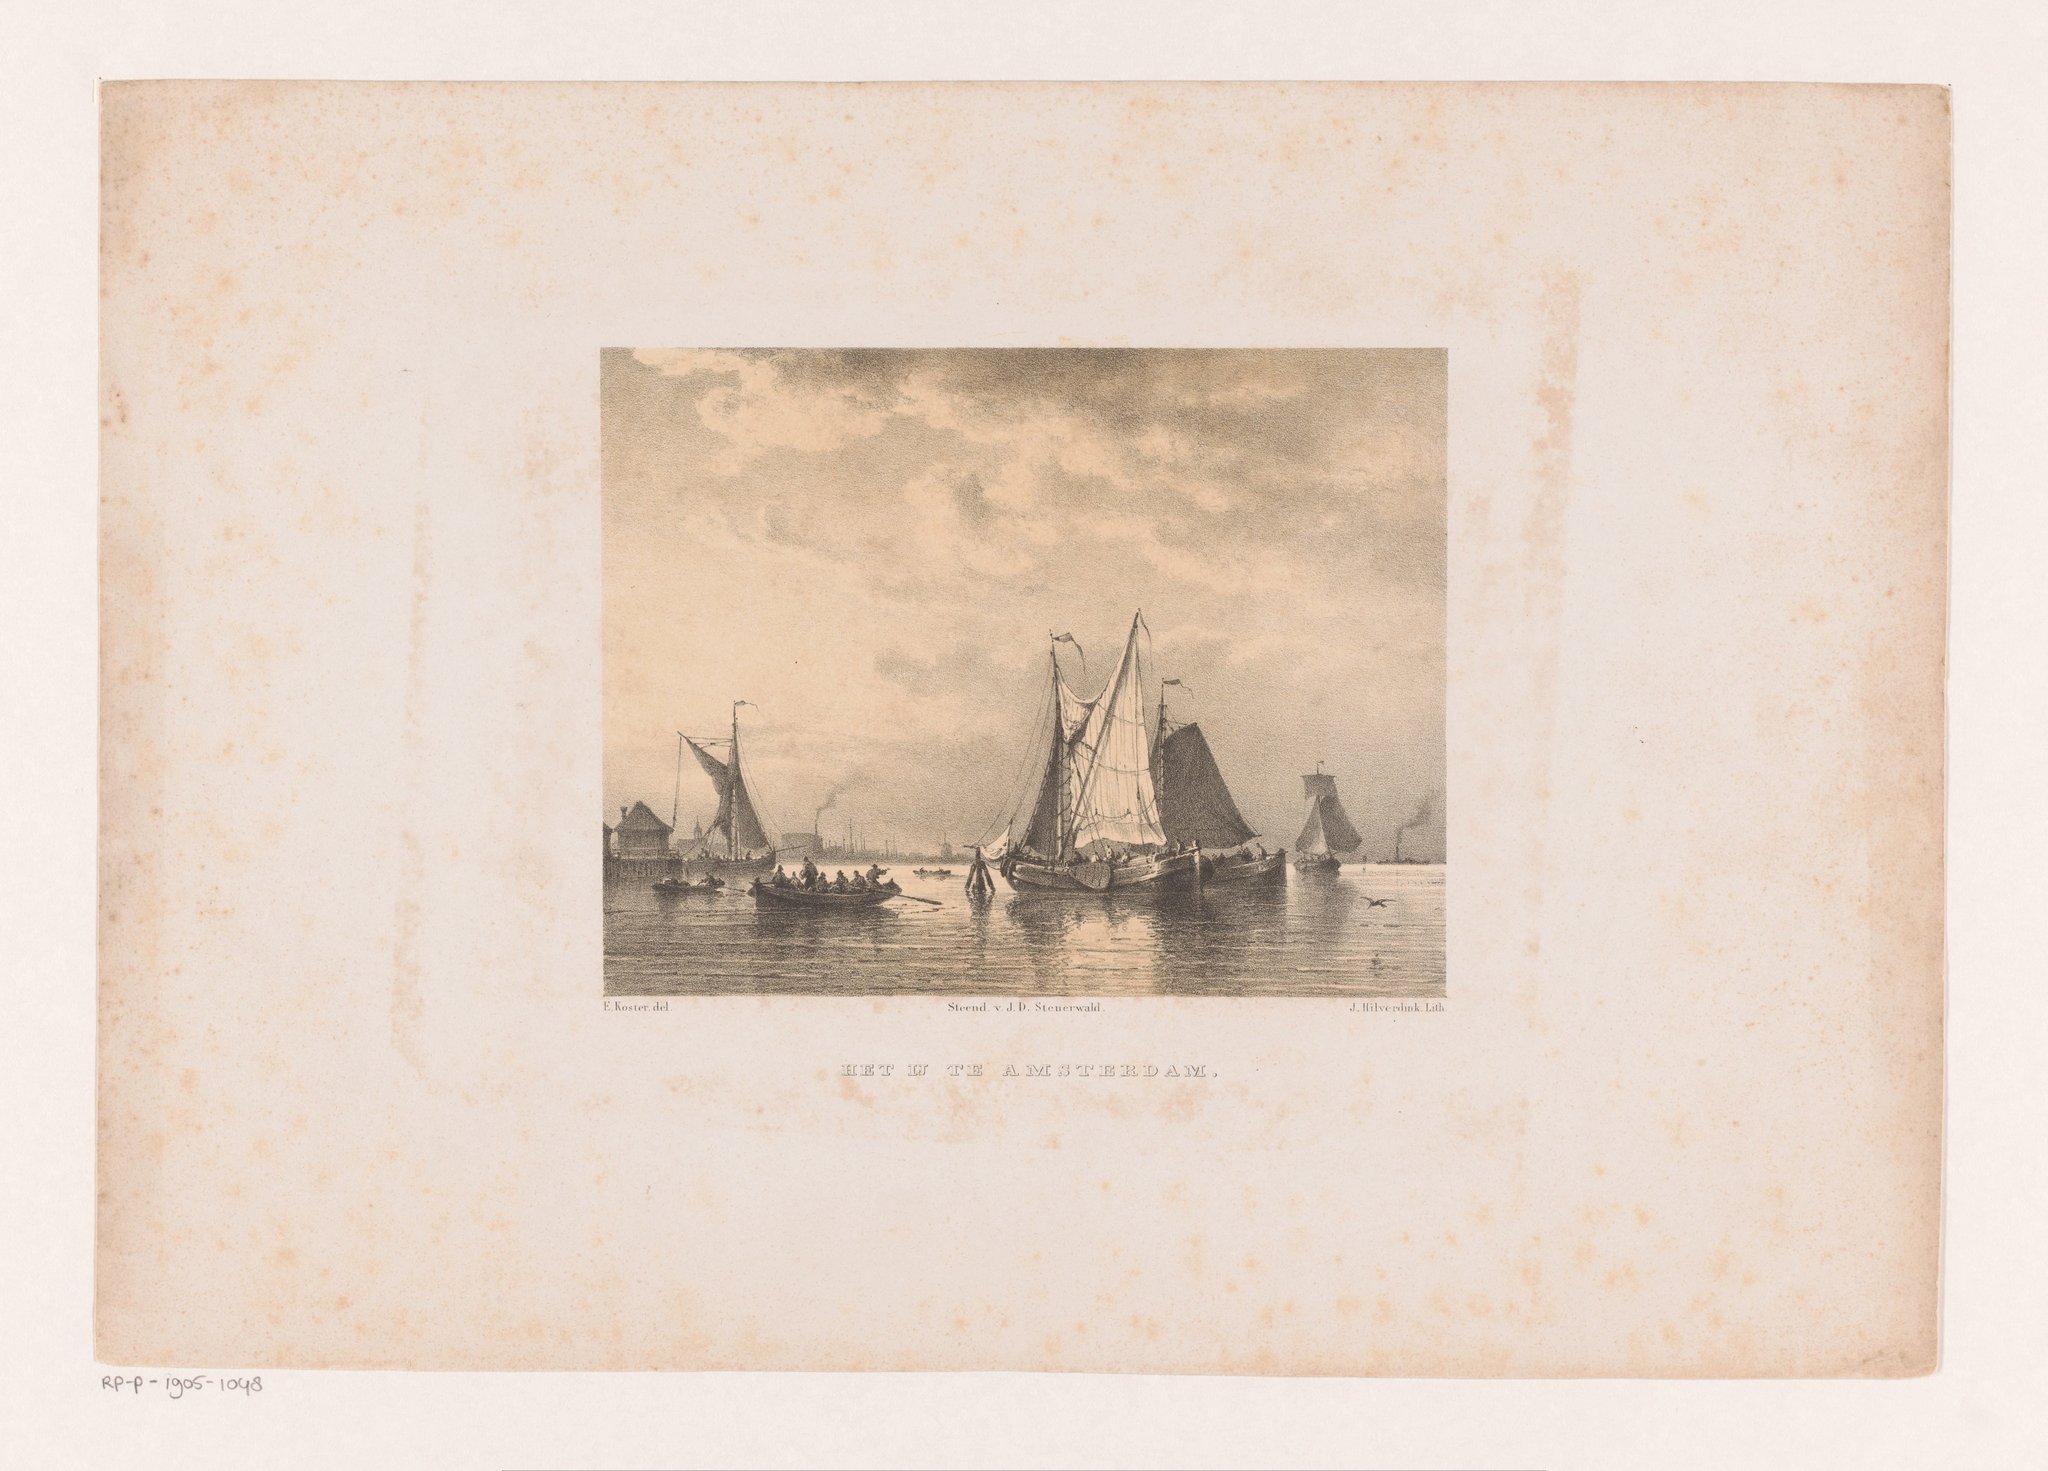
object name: print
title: Het IJ te Amsterdam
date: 1858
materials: paper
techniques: tone lithography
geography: amsterdam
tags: smoke-stack, sailing-ship, sailing-boat, factory in landscape, rowing facing backward, pulling, river (+ landscape with figures, staffage)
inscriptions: collector's mark: Lugt 2228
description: Deze prent komt uit: Koster, E. 'E. Koster's schetsboek: Nederlandsche Stads- en Havengezichten, uitgegeven onder medewerking van de maatschappij Arti et Amicitiae, Amsterdam, F. Buffa en Zn., e.a.' Amsterdam 1858.